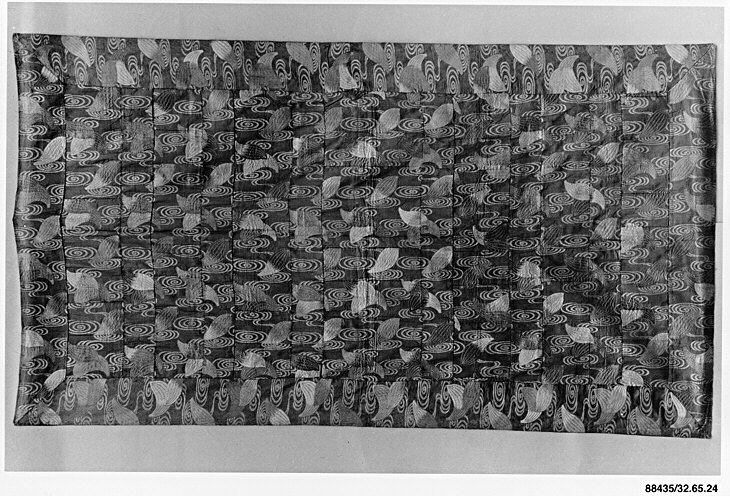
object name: kesa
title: Buddhist Priest's Robe (Kesa) with Pattern of Lotus Petals on Water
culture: japanese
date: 1701-1800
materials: metal thread, silk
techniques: brocade, weave